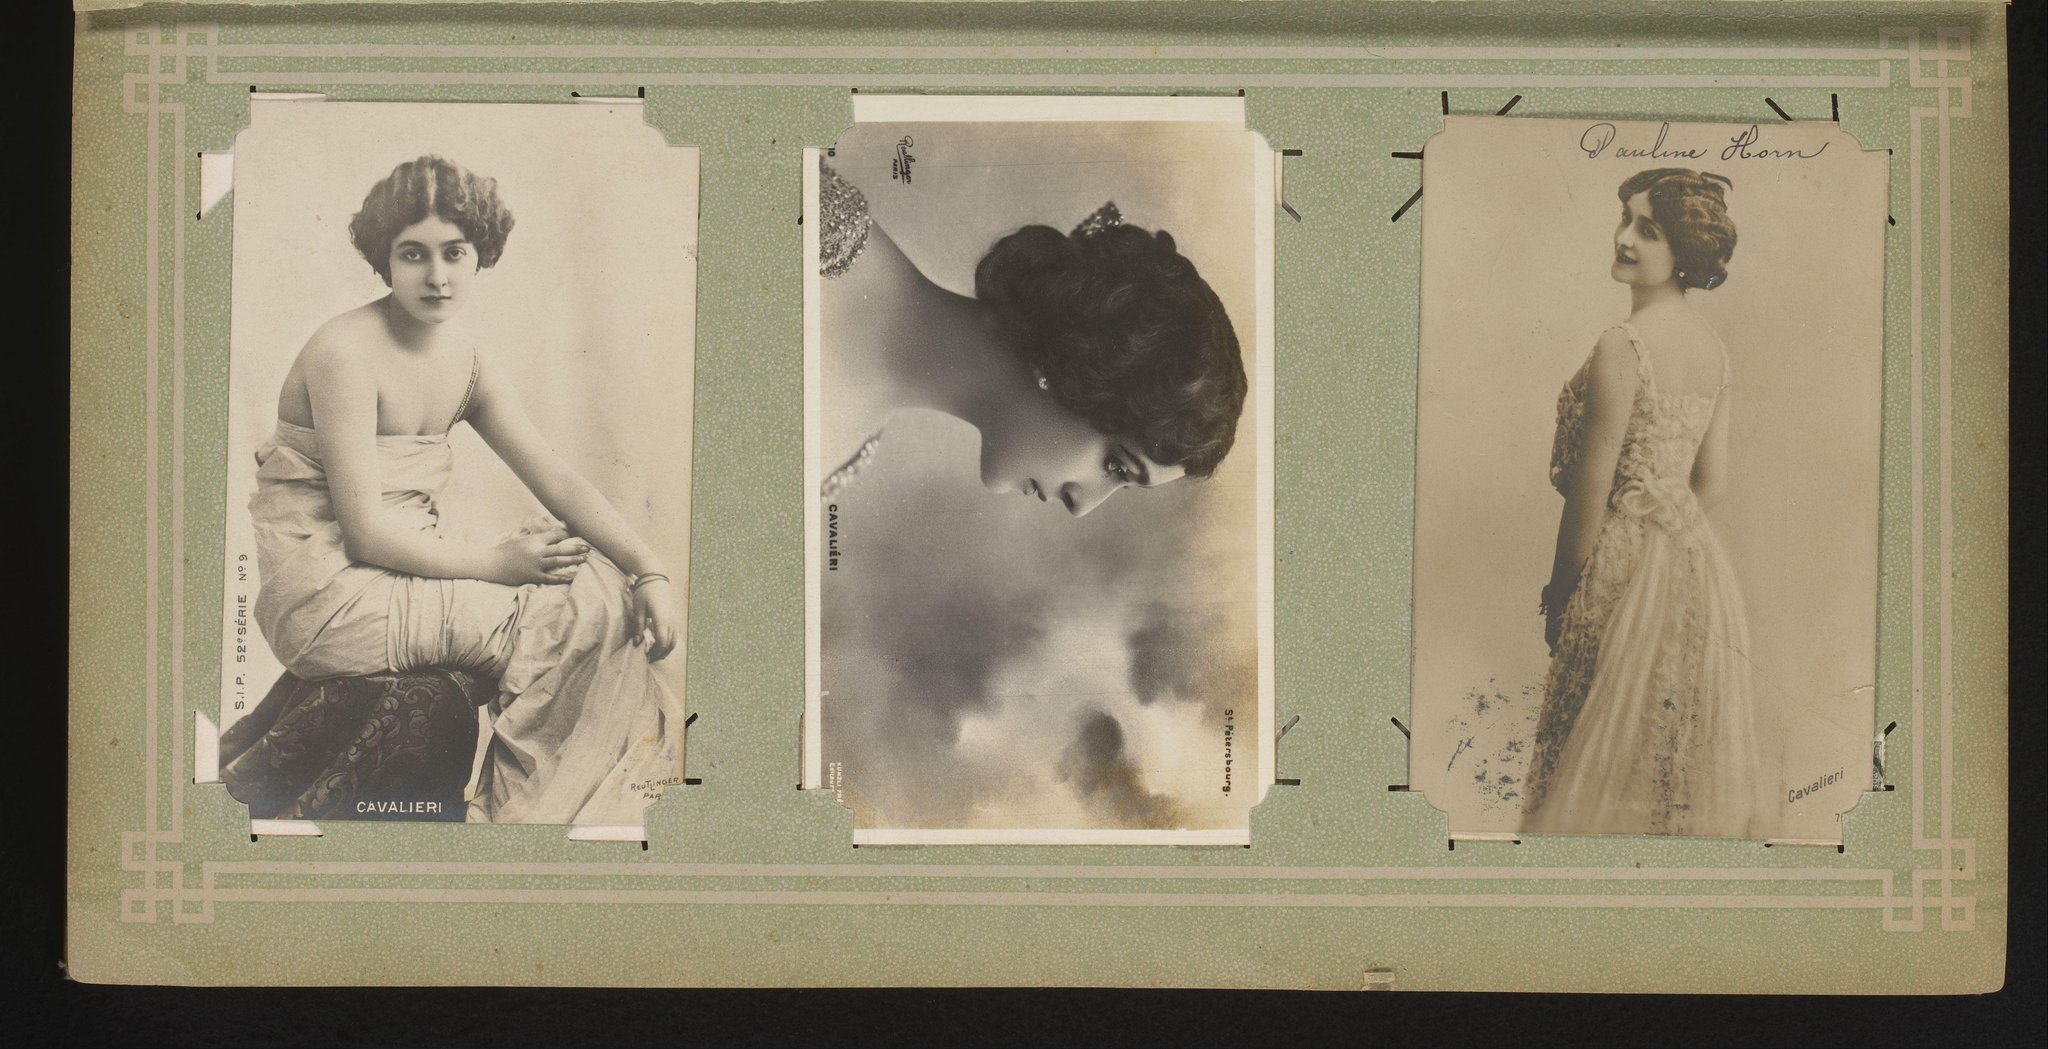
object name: photograph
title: Drie portretten van Lina Cavalieri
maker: Anonymous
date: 1900-1930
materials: cardboard, ink, photographic support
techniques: gelatin silver print, pen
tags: historical persons - bb - woman, portrait of opera-singer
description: Deze foto's maken deel uit van een album.